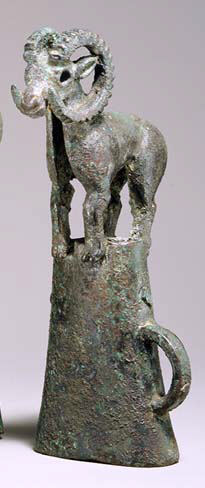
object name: finial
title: Finial with Wild Ram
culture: chinese, northeast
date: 700-501 BCE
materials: bronze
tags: rams